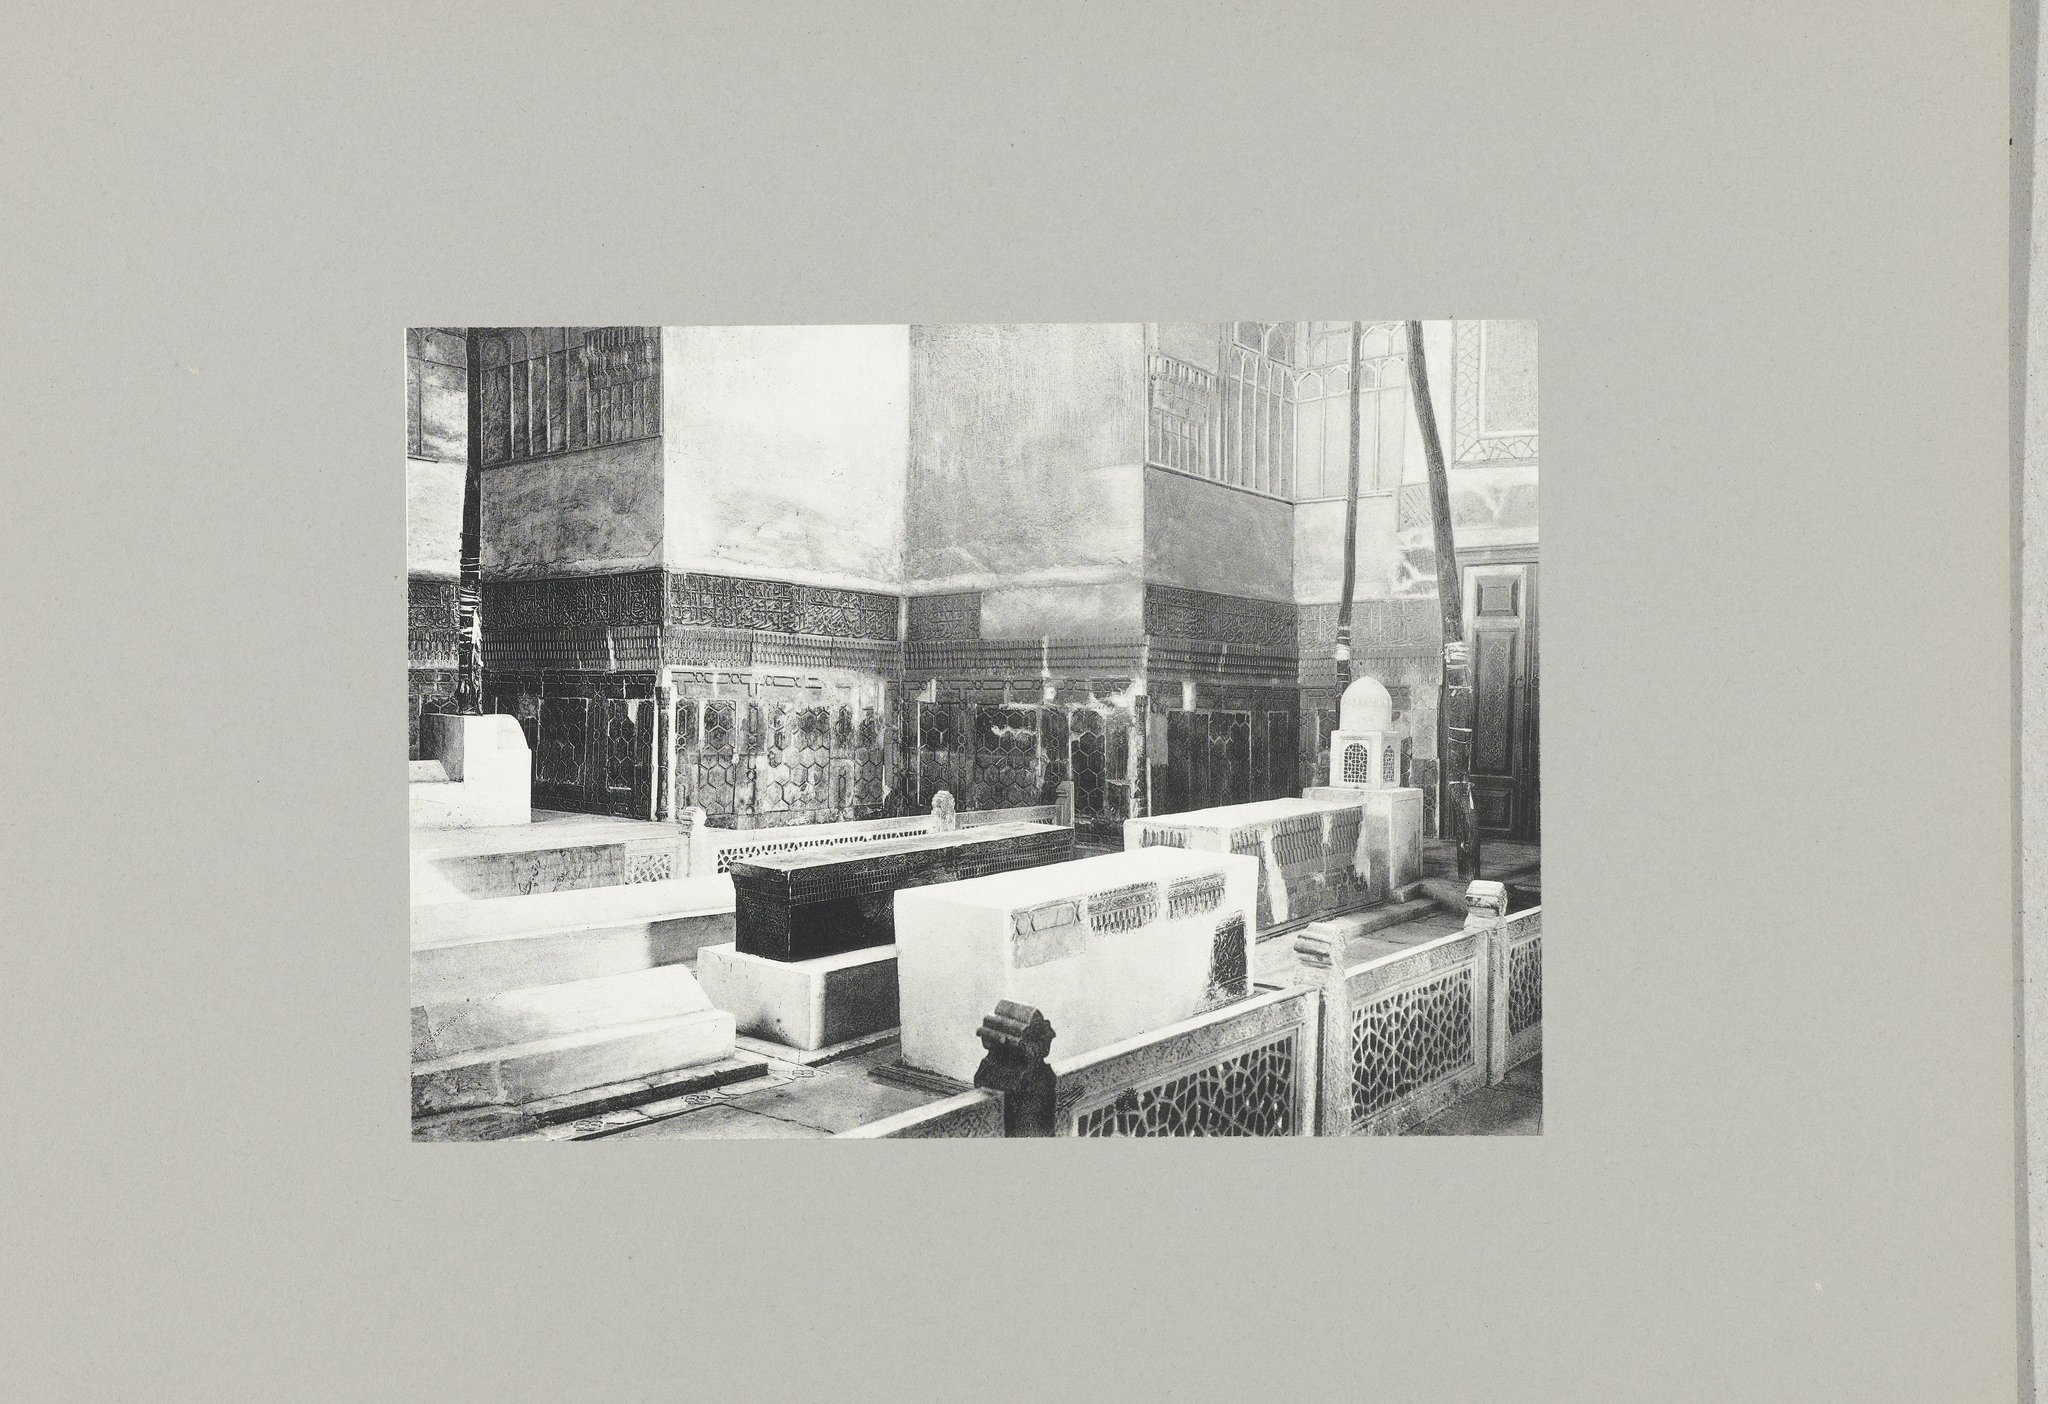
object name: photomechanical print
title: Ruimte in het mausoleum van Timur te Samarkand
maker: Anonymous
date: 1895-1915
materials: cardboard, paper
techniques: photograph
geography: samarqand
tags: samarqand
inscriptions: annotation: ‘7. Inwendig Mausoleum van Timur of Tamerlan.’